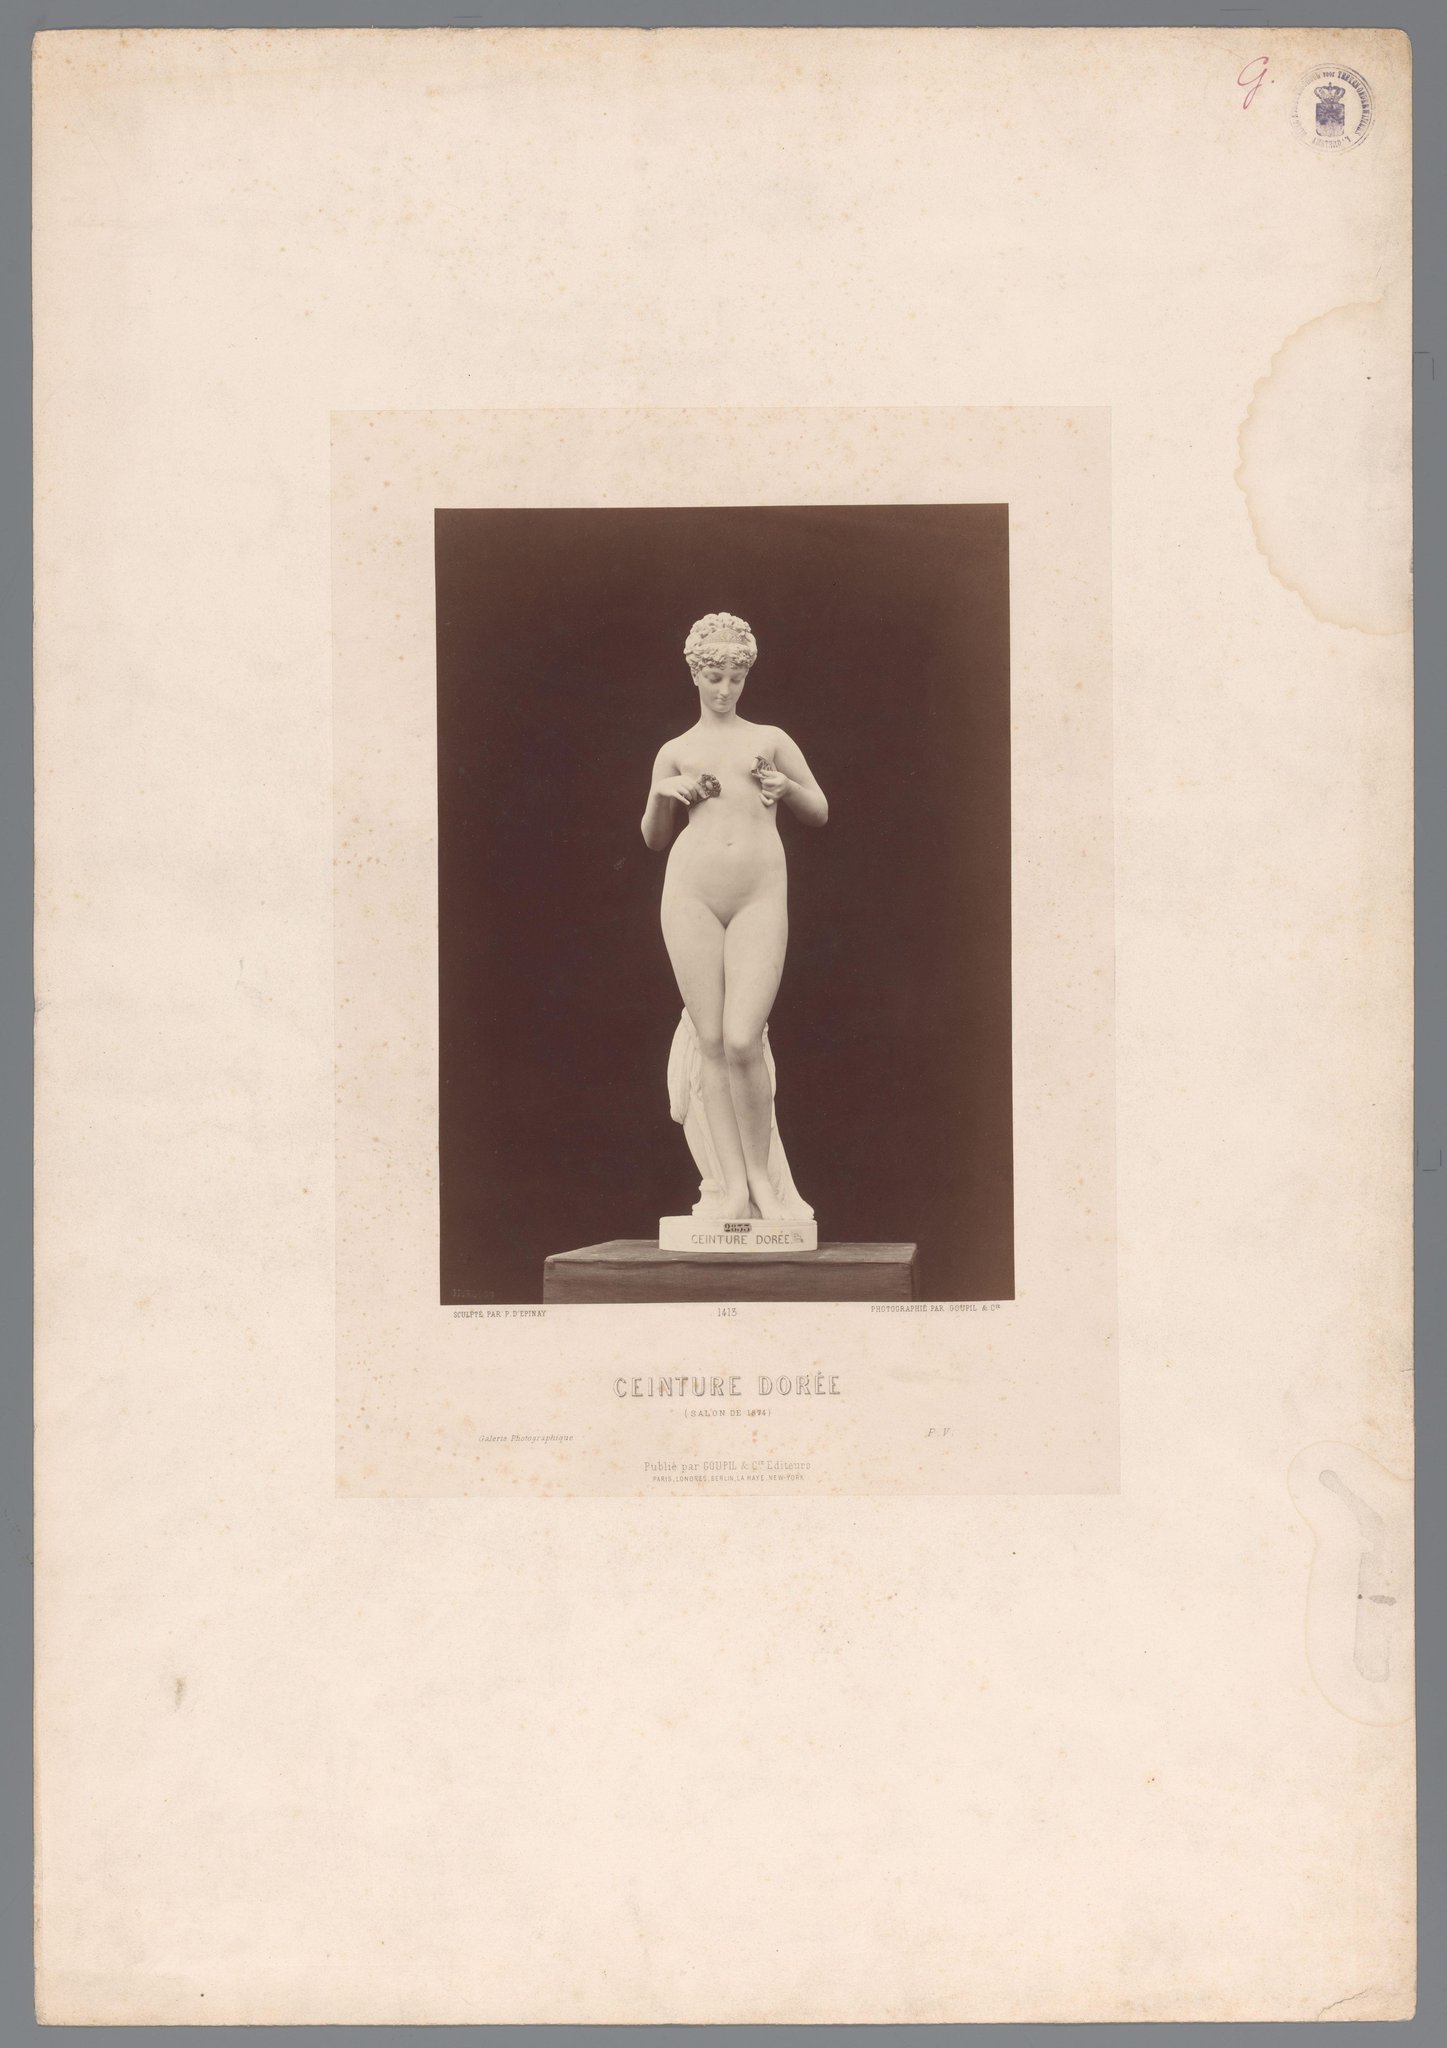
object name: photograph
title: Ceinture dorée (Salon de 1874)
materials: cardboard, paper, photographic support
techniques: albumen print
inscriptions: : ‘G’, stamp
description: Sculptuur door P. d'Epinay van een naakte staande vrouw die een ceintuur om haar middel doet.